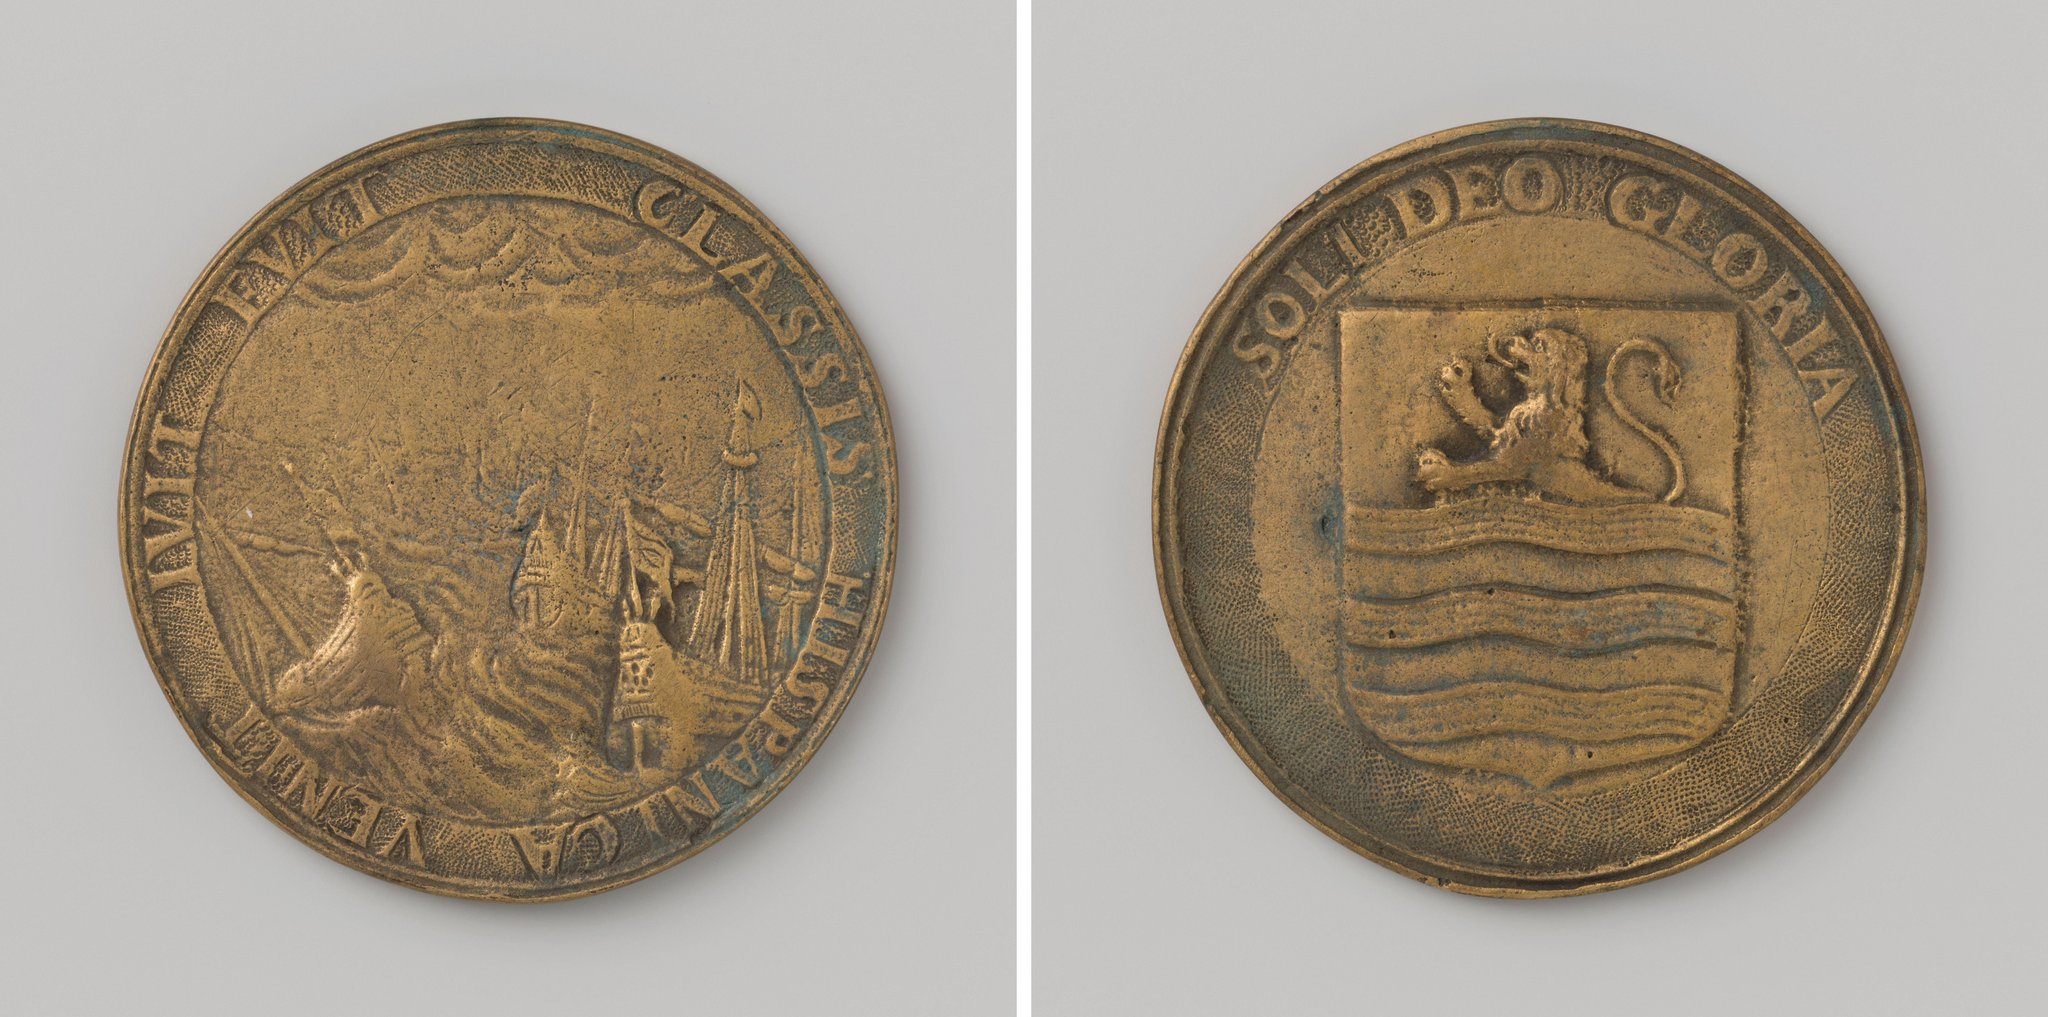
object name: copy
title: Vergaan van de Spaanse armada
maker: Anonymous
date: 1588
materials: copper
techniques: casting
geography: zeeland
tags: tachtigjarige oorlog, vergaan van de spaanse armada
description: Koperen penning. Voorzijde: uiteengeslagen schepen van armada lijden schipbreuk binnen omschrift. Keerzijde: wapenschild binnen omschrift